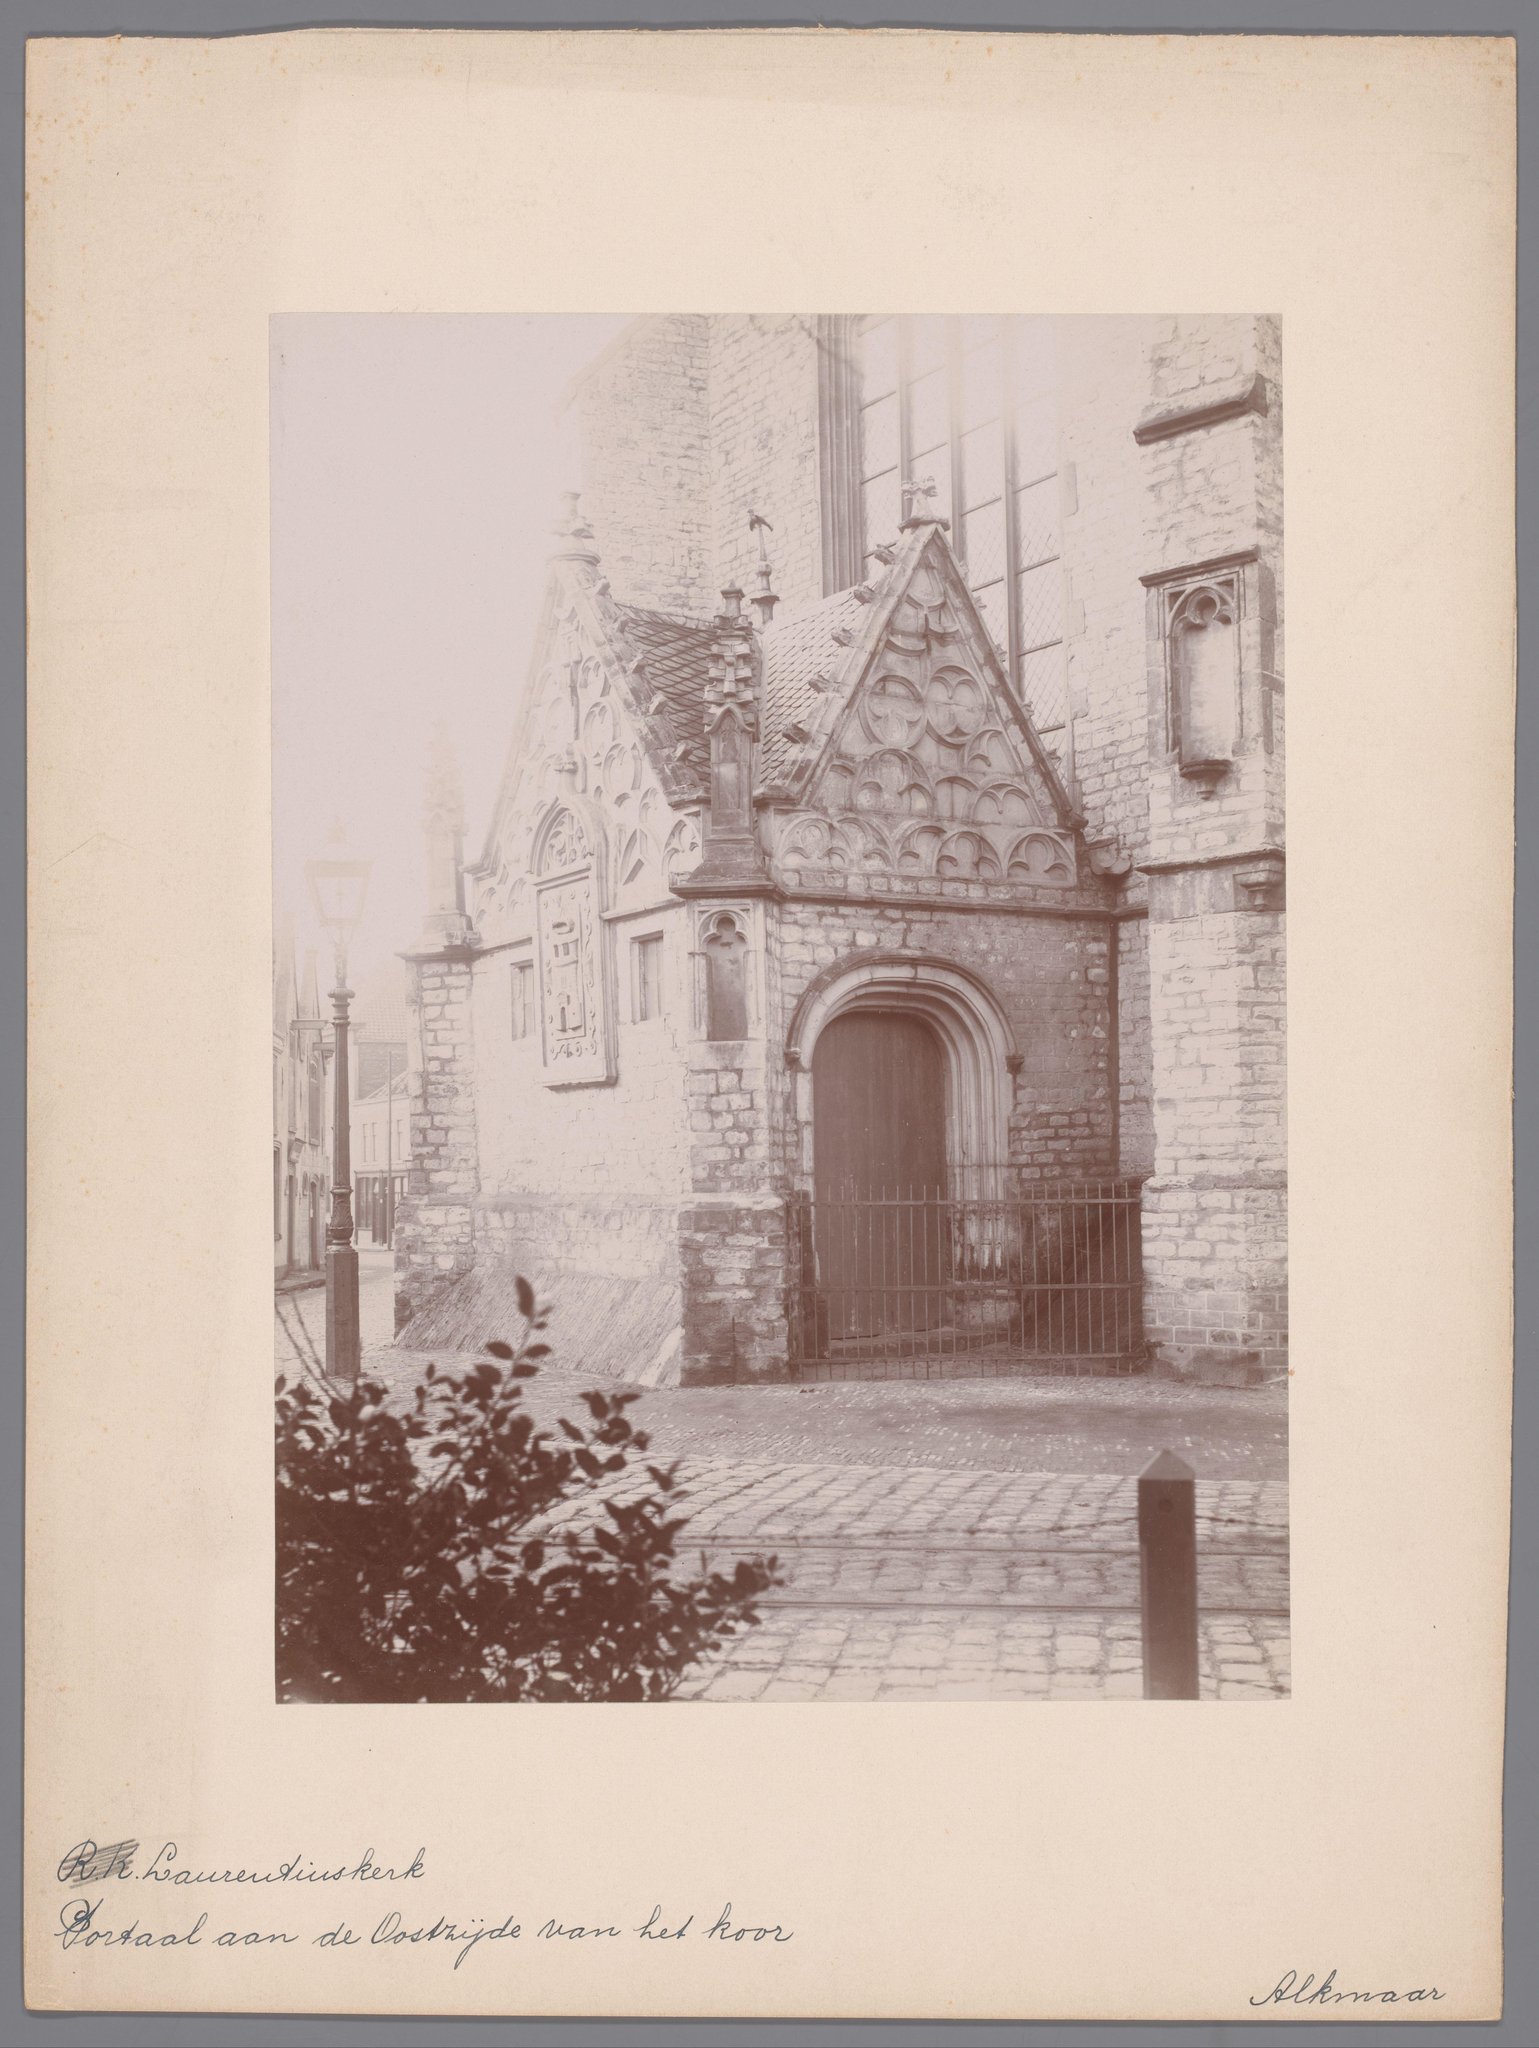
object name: photograph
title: Portaal aan de oostzijde van het koor van de Grote of Sint-Laurenskerk te Alkmaar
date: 1890-1900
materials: cardboard, photographic support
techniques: gelatin silver print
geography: alkmaar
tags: parts of church exterior and annexes: portal, parts of church exterior and annexes: choir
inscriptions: annotation: ‘Laurentiuskerk/ Prtaal aan de oostzijde van het koor/ Alkmaar’, annotation: ‘Alkmaar/ Portaal aan de oostzijde van het koor der R.K. Laurentius kerk/ (N.H.)’